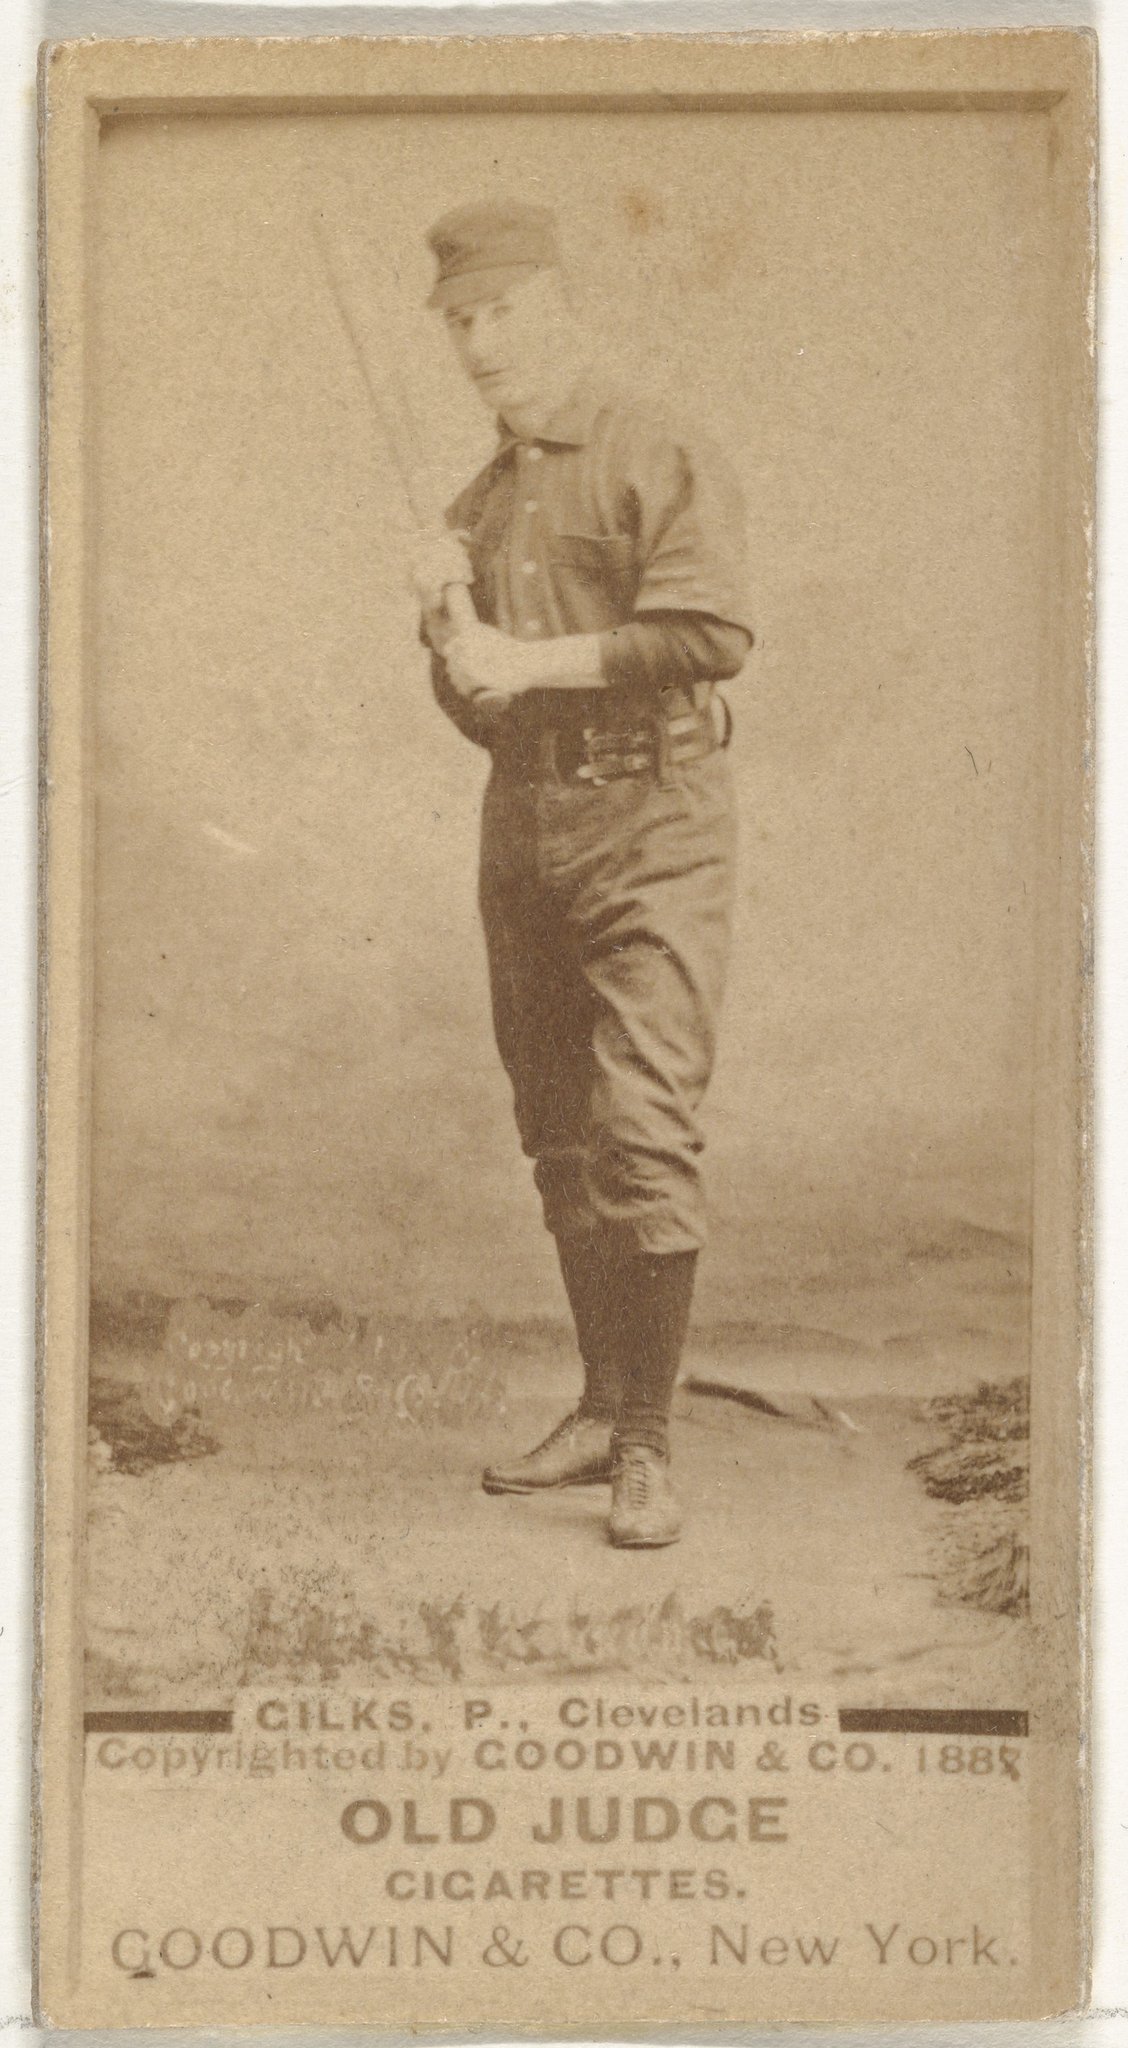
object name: baseball card, photograph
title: Robert James "Bob" Gilks, Pitcher, Cleveland, from the Old Judge series (N172) for Old Judge Cigarettes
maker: goodwin & company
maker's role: publisher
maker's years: 1850-1950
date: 1888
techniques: albumen silver print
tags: men,portraits,baseball,athletes